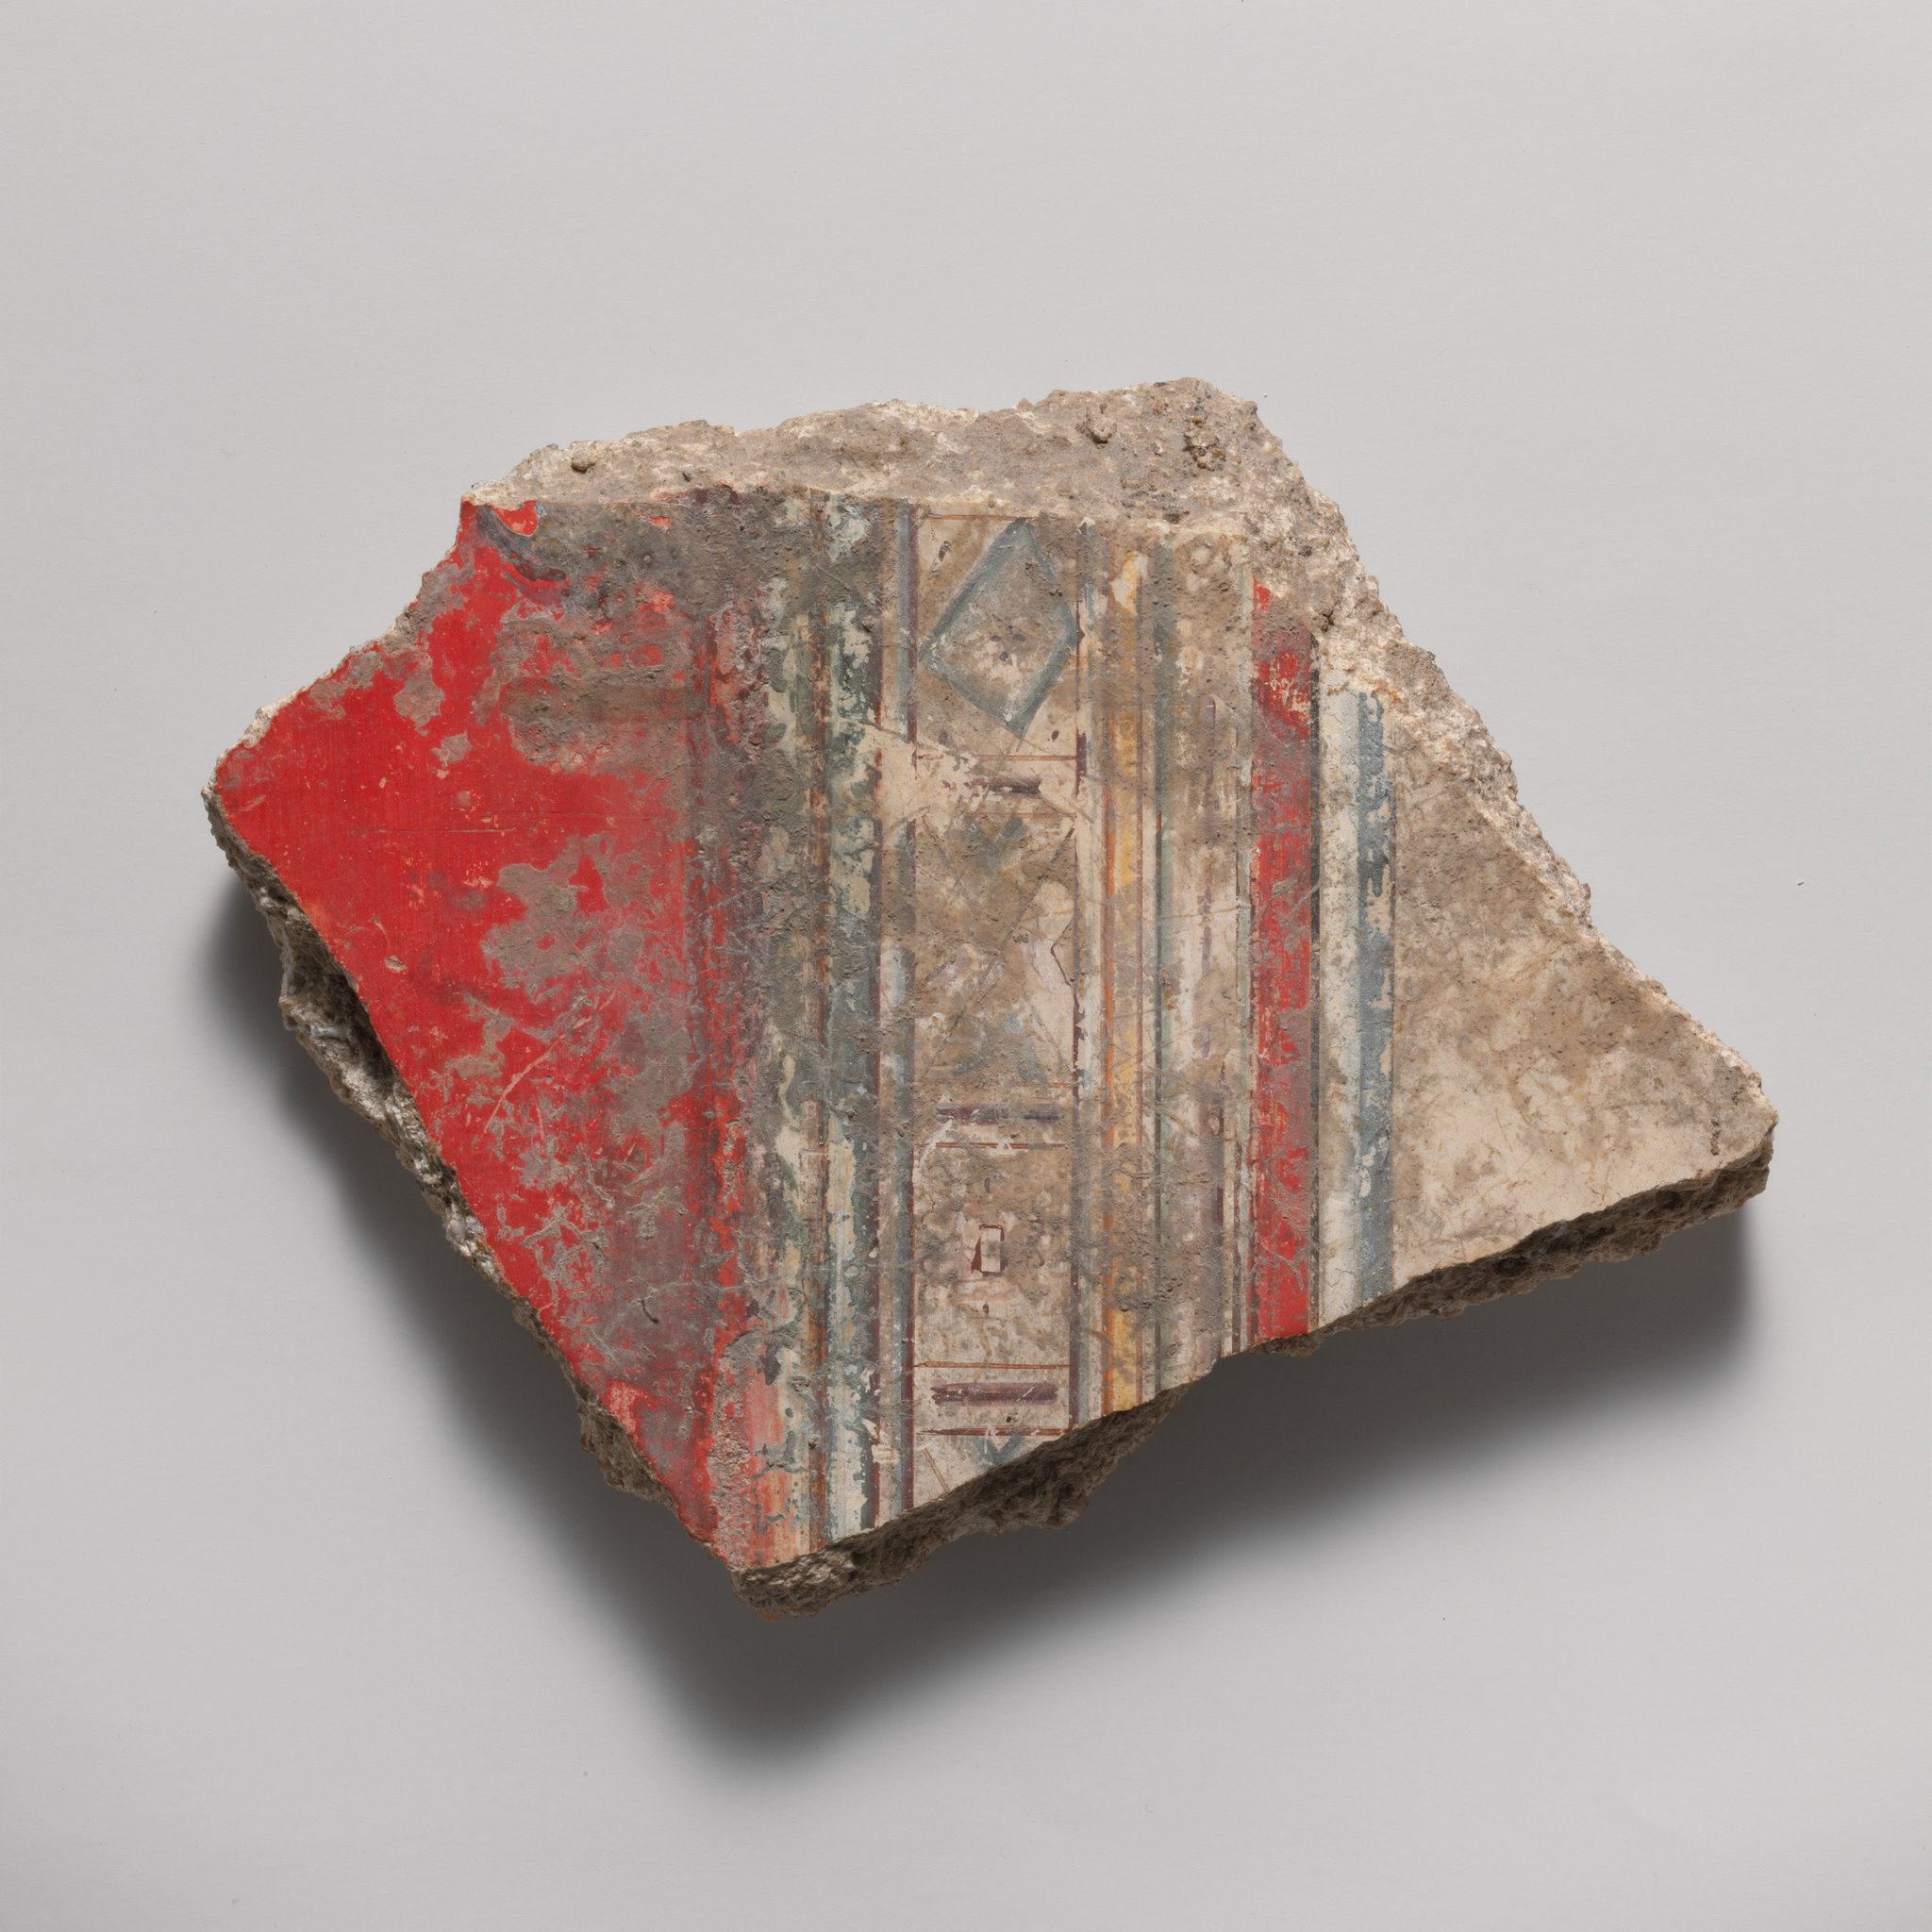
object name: wall painting fragment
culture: roman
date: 1-100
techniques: fresco